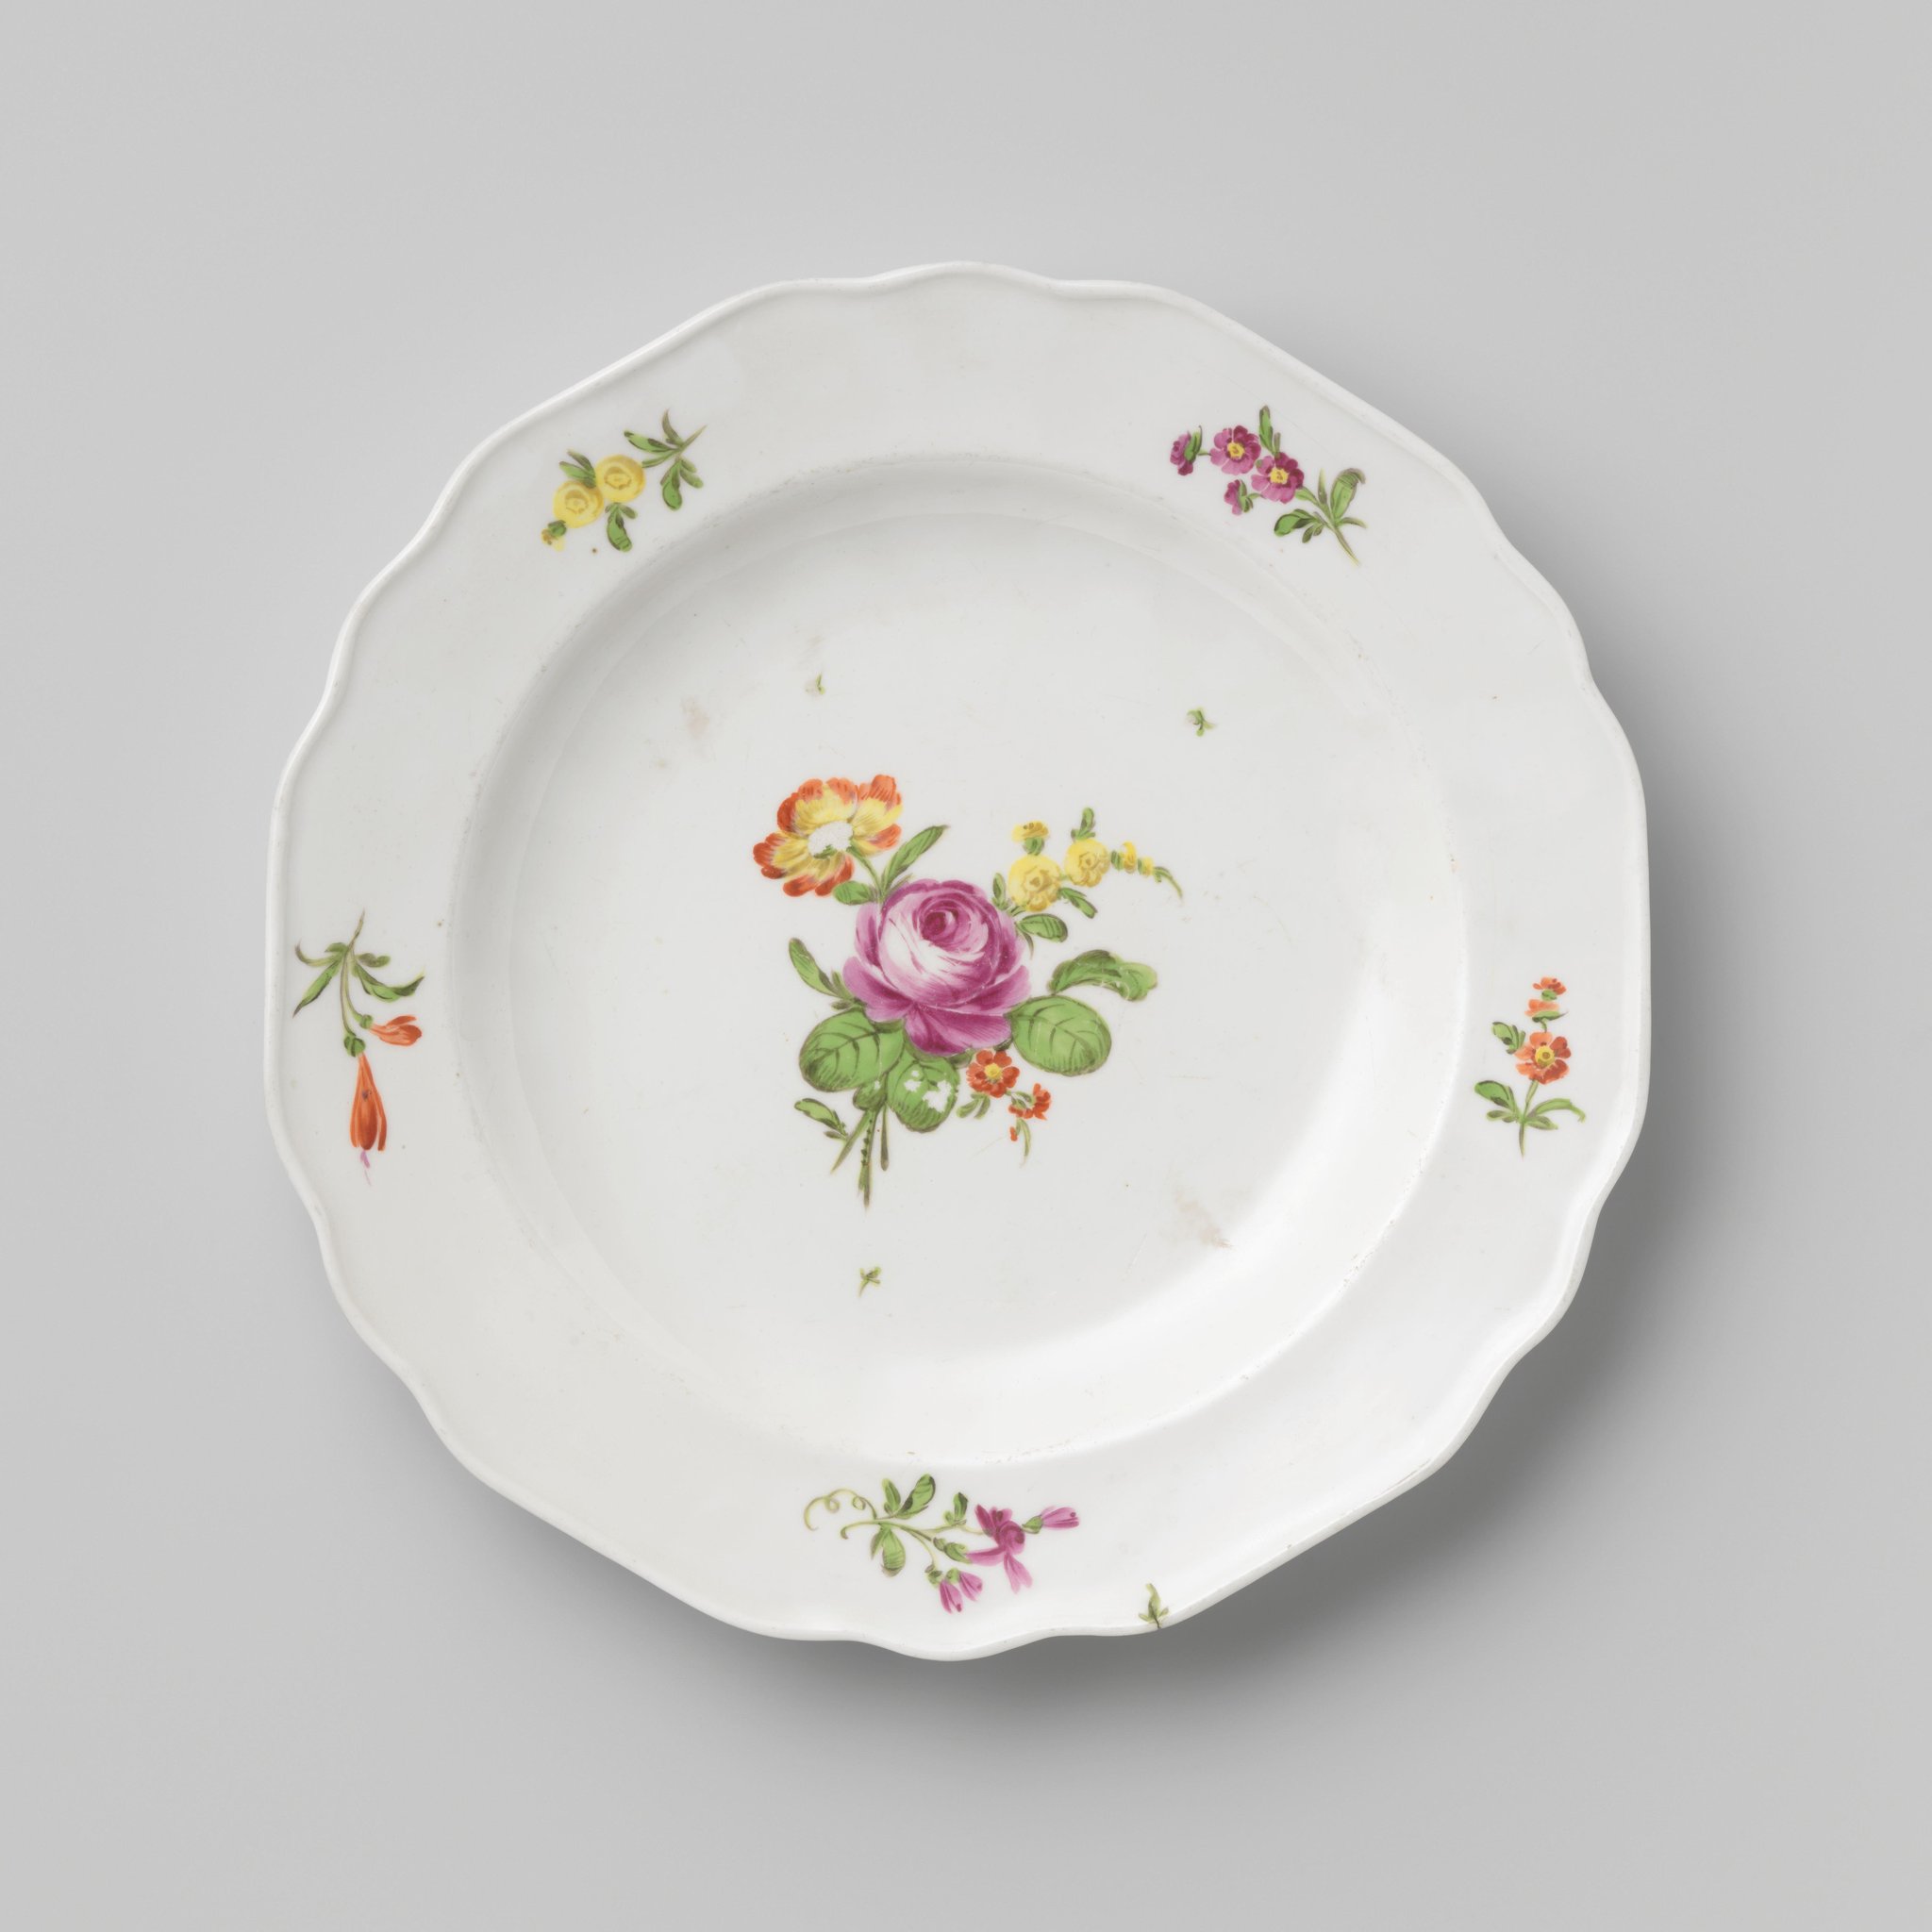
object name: plate dish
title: Plate with a bouquet and flower sprays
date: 1800-1849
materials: glaze, paint, porcelain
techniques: firing, forming, turning, vitrification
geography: vienna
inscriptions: mark: ‘schild/ P/ 40/ 88’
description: Bord van porselein met een gelobde rand, beschilderd op het glazuur in rood, groen, geel en paars. Op het plat een boeket van verschillende bloemen (o.a. pioenroos) omgeven door losse takjes en op de rand vijf bloemtakken. Gemerkt op de onderzijde met het schild, de letter P en de nummers 40 en 88. Op enkele plekken heeft het email losgelaten.